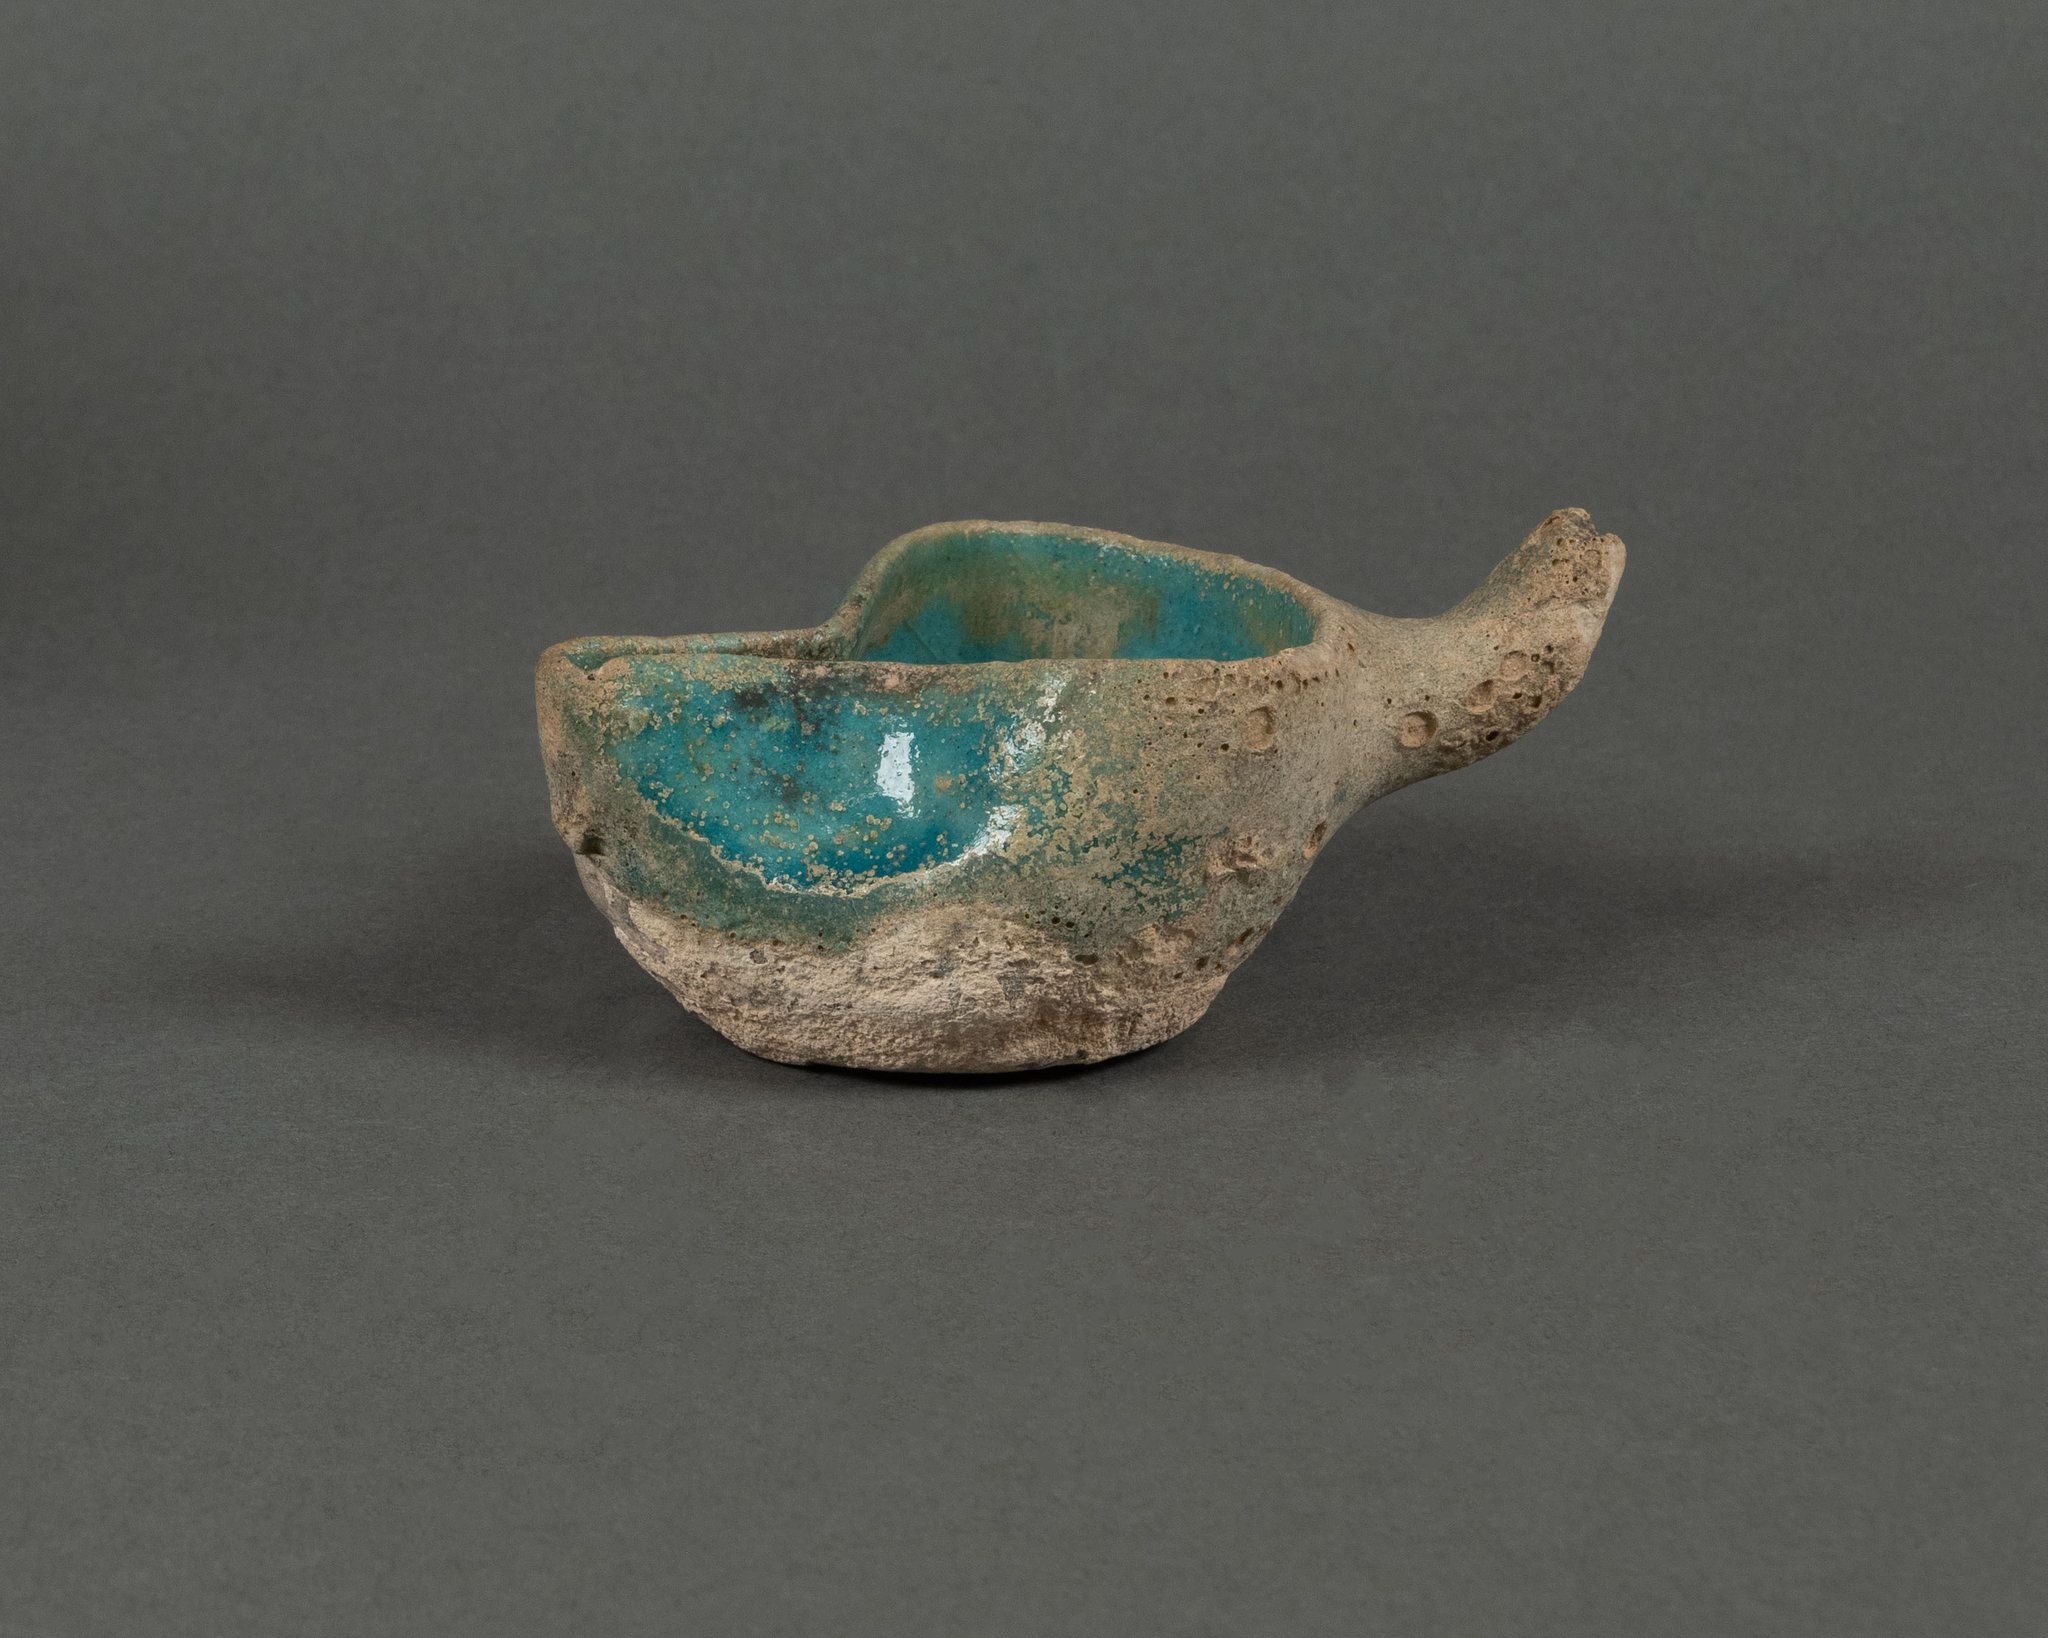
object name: lamp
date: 801-1000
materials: earthenware, glaze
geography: iran